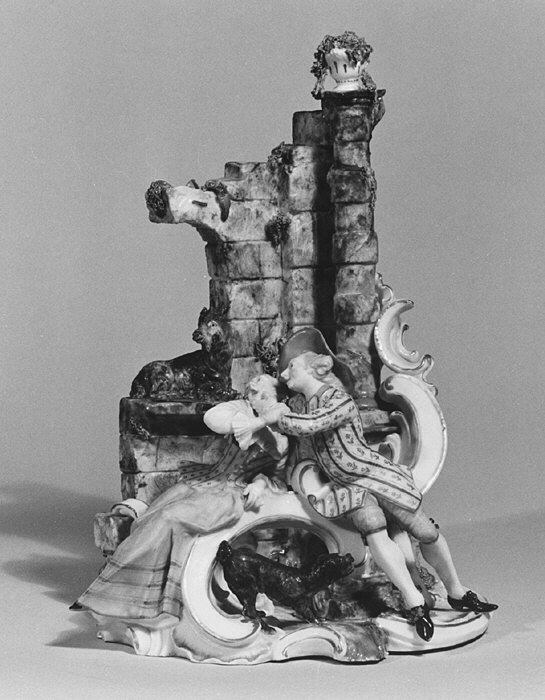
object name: group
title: Love amid ruin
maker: nymphenburg porcelain manufactory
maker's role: manufactory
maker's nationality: german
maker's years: 1747-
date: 1756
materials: hard paste porcelain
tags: animals,ruins,men,women